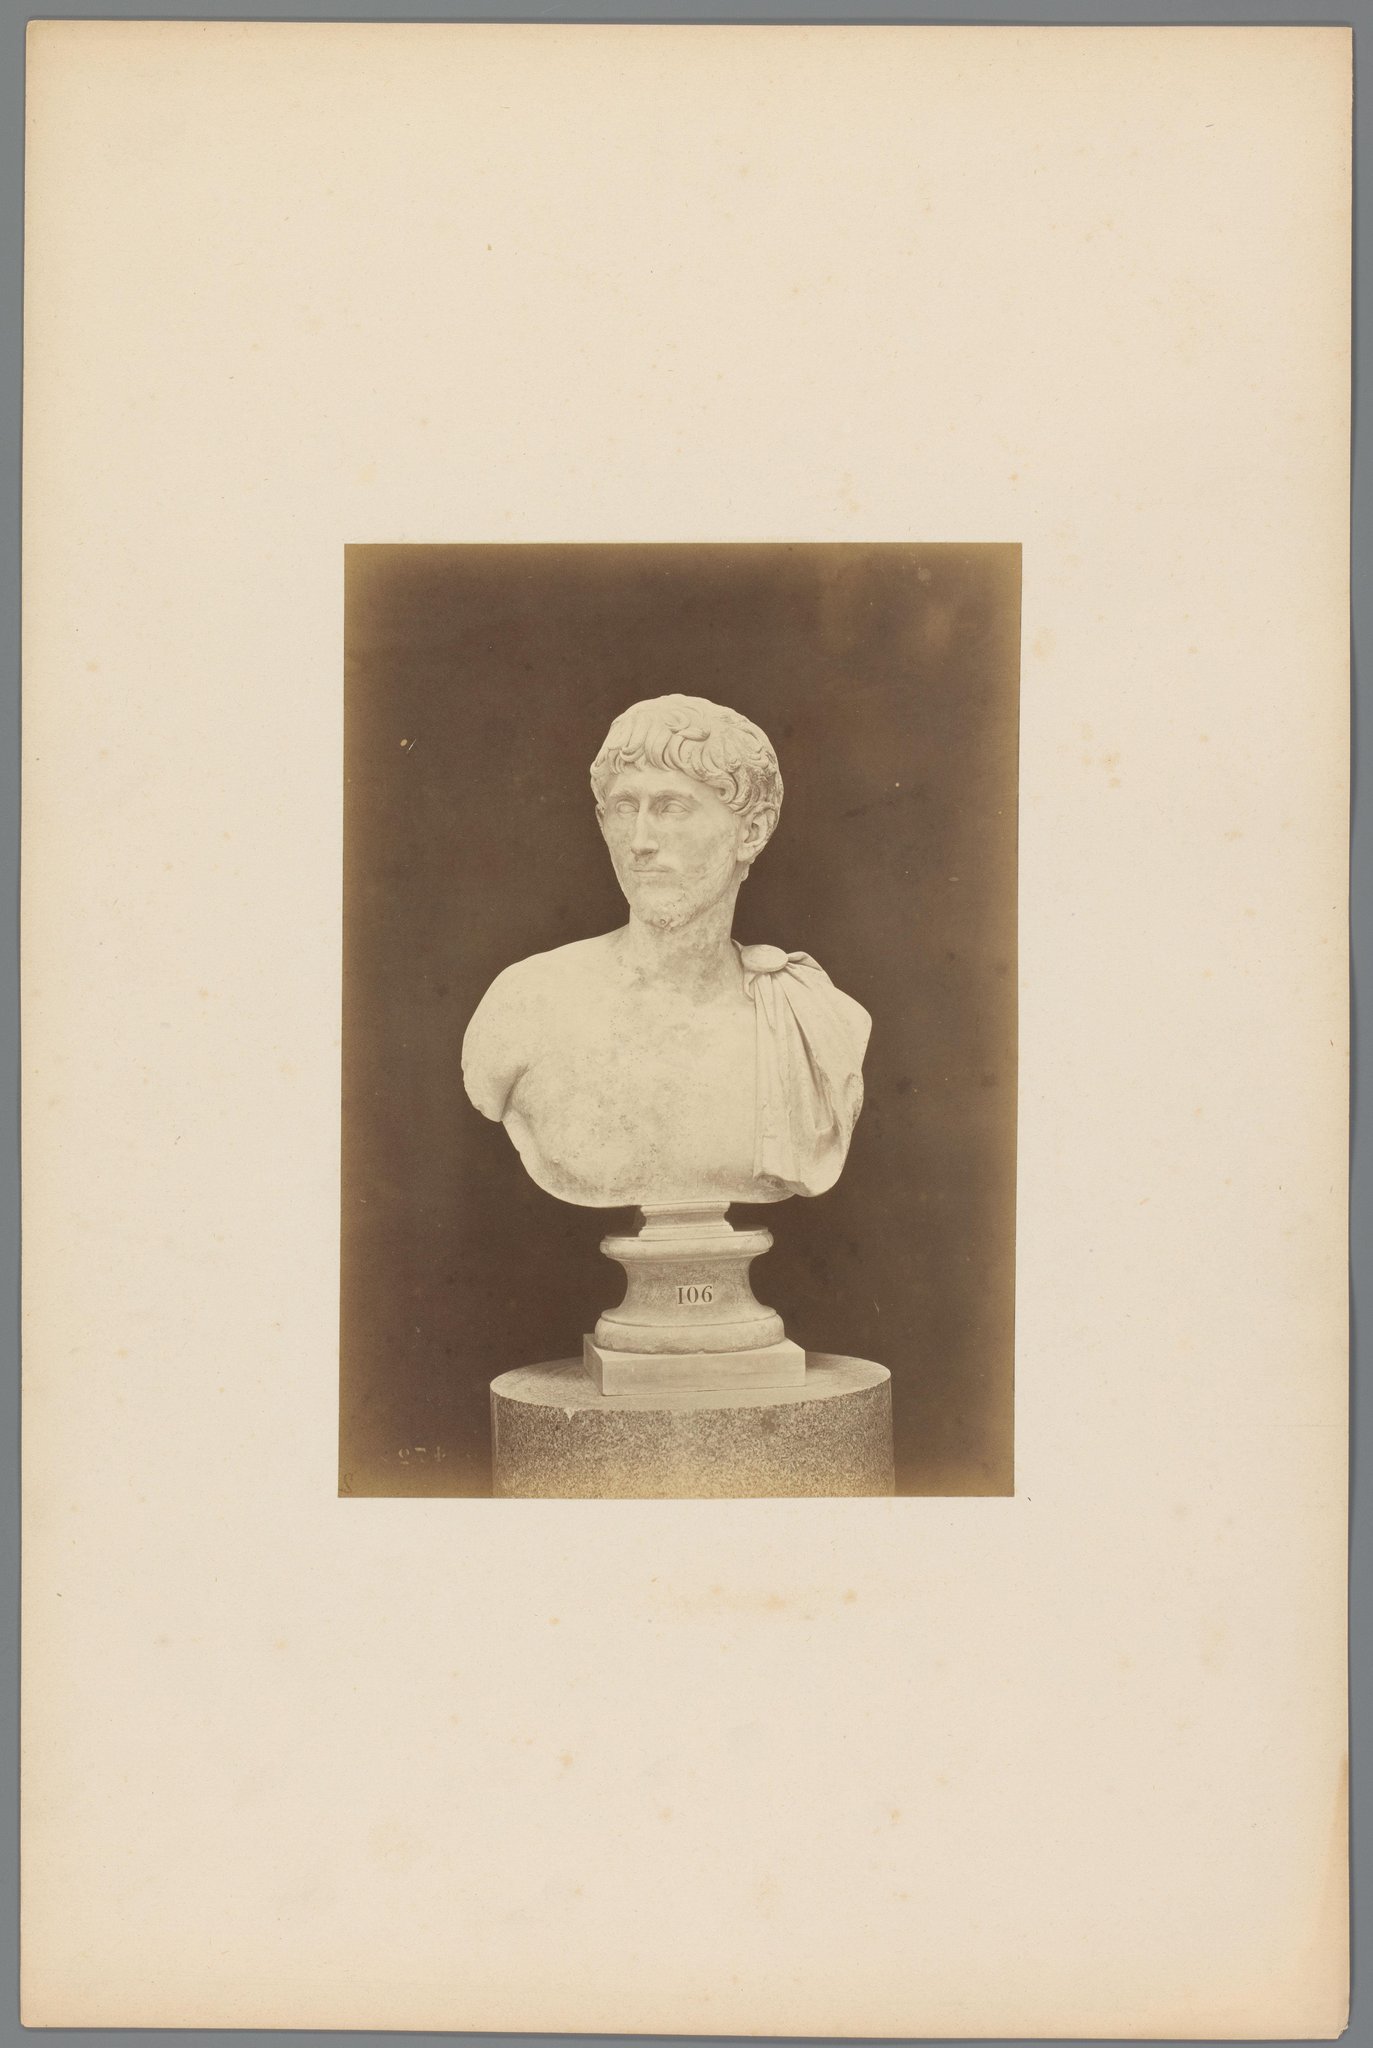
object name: photograph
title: Buste van een man, vermoedelijk een Romeinse keizer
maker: Anonymous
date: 1851-1900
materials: cardboard, paper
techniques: albumen print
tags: head (human), piece of sculpture, reproduction of a piece of sculpture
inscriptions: number: ‘274’